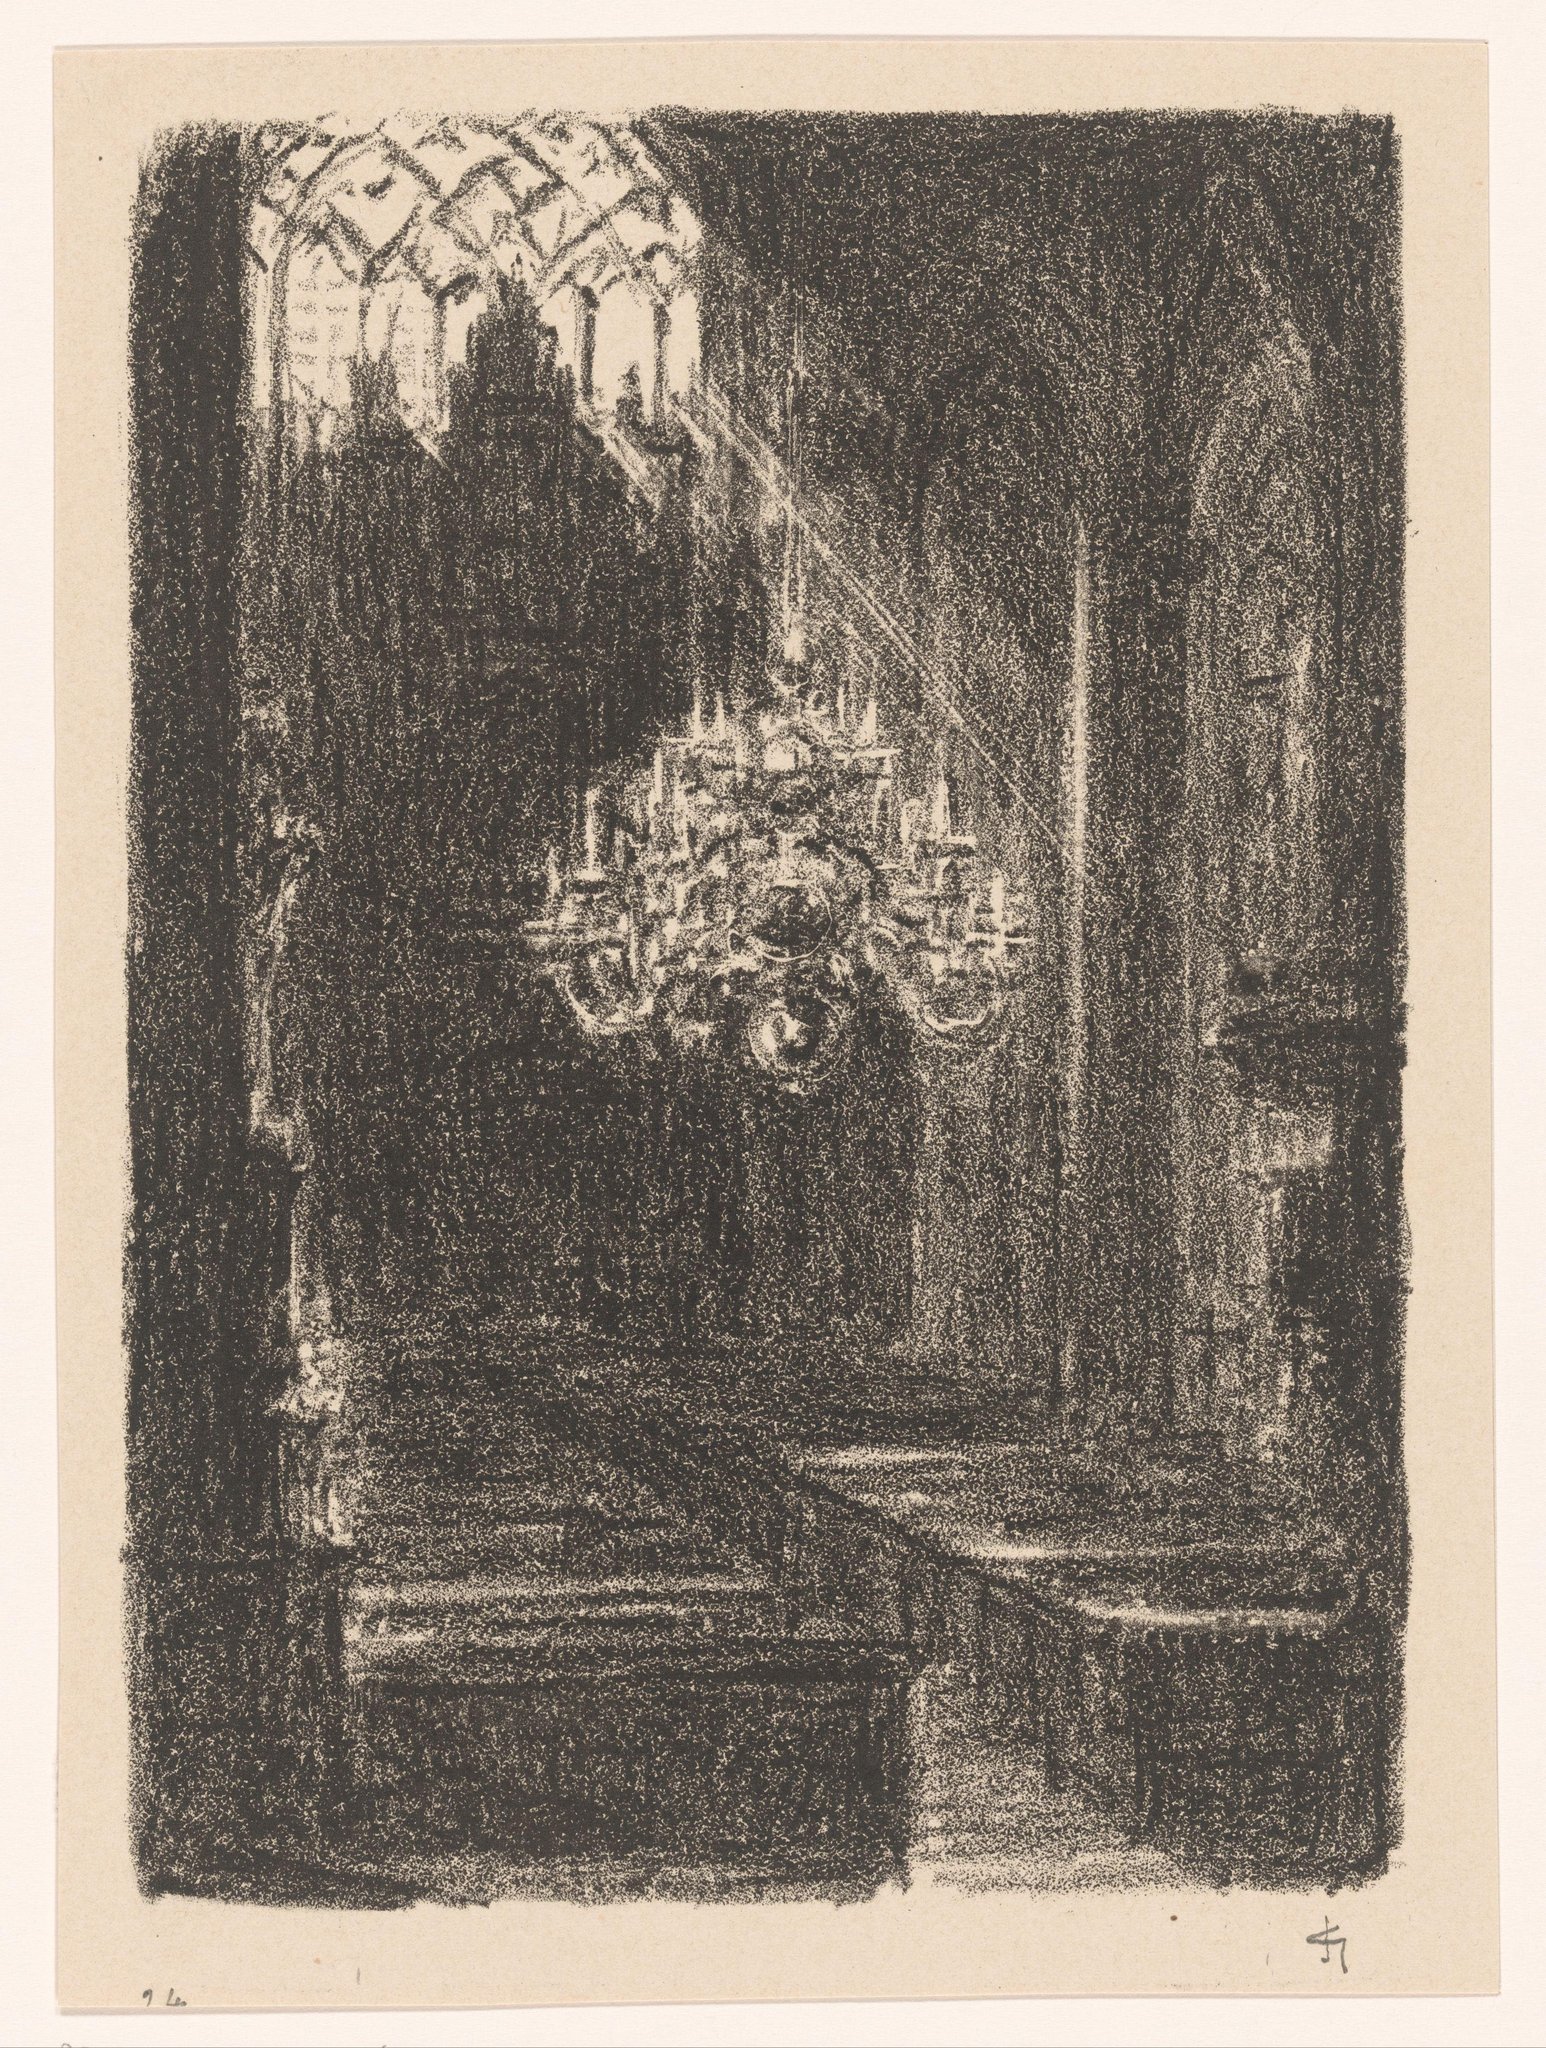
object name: print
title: Kerkinterieur in Kleef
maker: carel nicolaas storm van s-gravesande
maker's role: draughtsman, print maker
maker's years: 1841-1924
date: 1851-1902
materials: paper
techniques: lithograph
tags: interior of church, cleves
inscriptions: collector's mark: Lugt 2228, number: ‘24’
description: Mogelijk vermeld in: Storm van 's-Gravesande, Charles. Catalogue des eaux-fortes et lithographies. New York: s.n., 1903, of in een onbekende latere uitgave van het manuscript. Vermoedelijk vermeld als catalogusnummer 24.